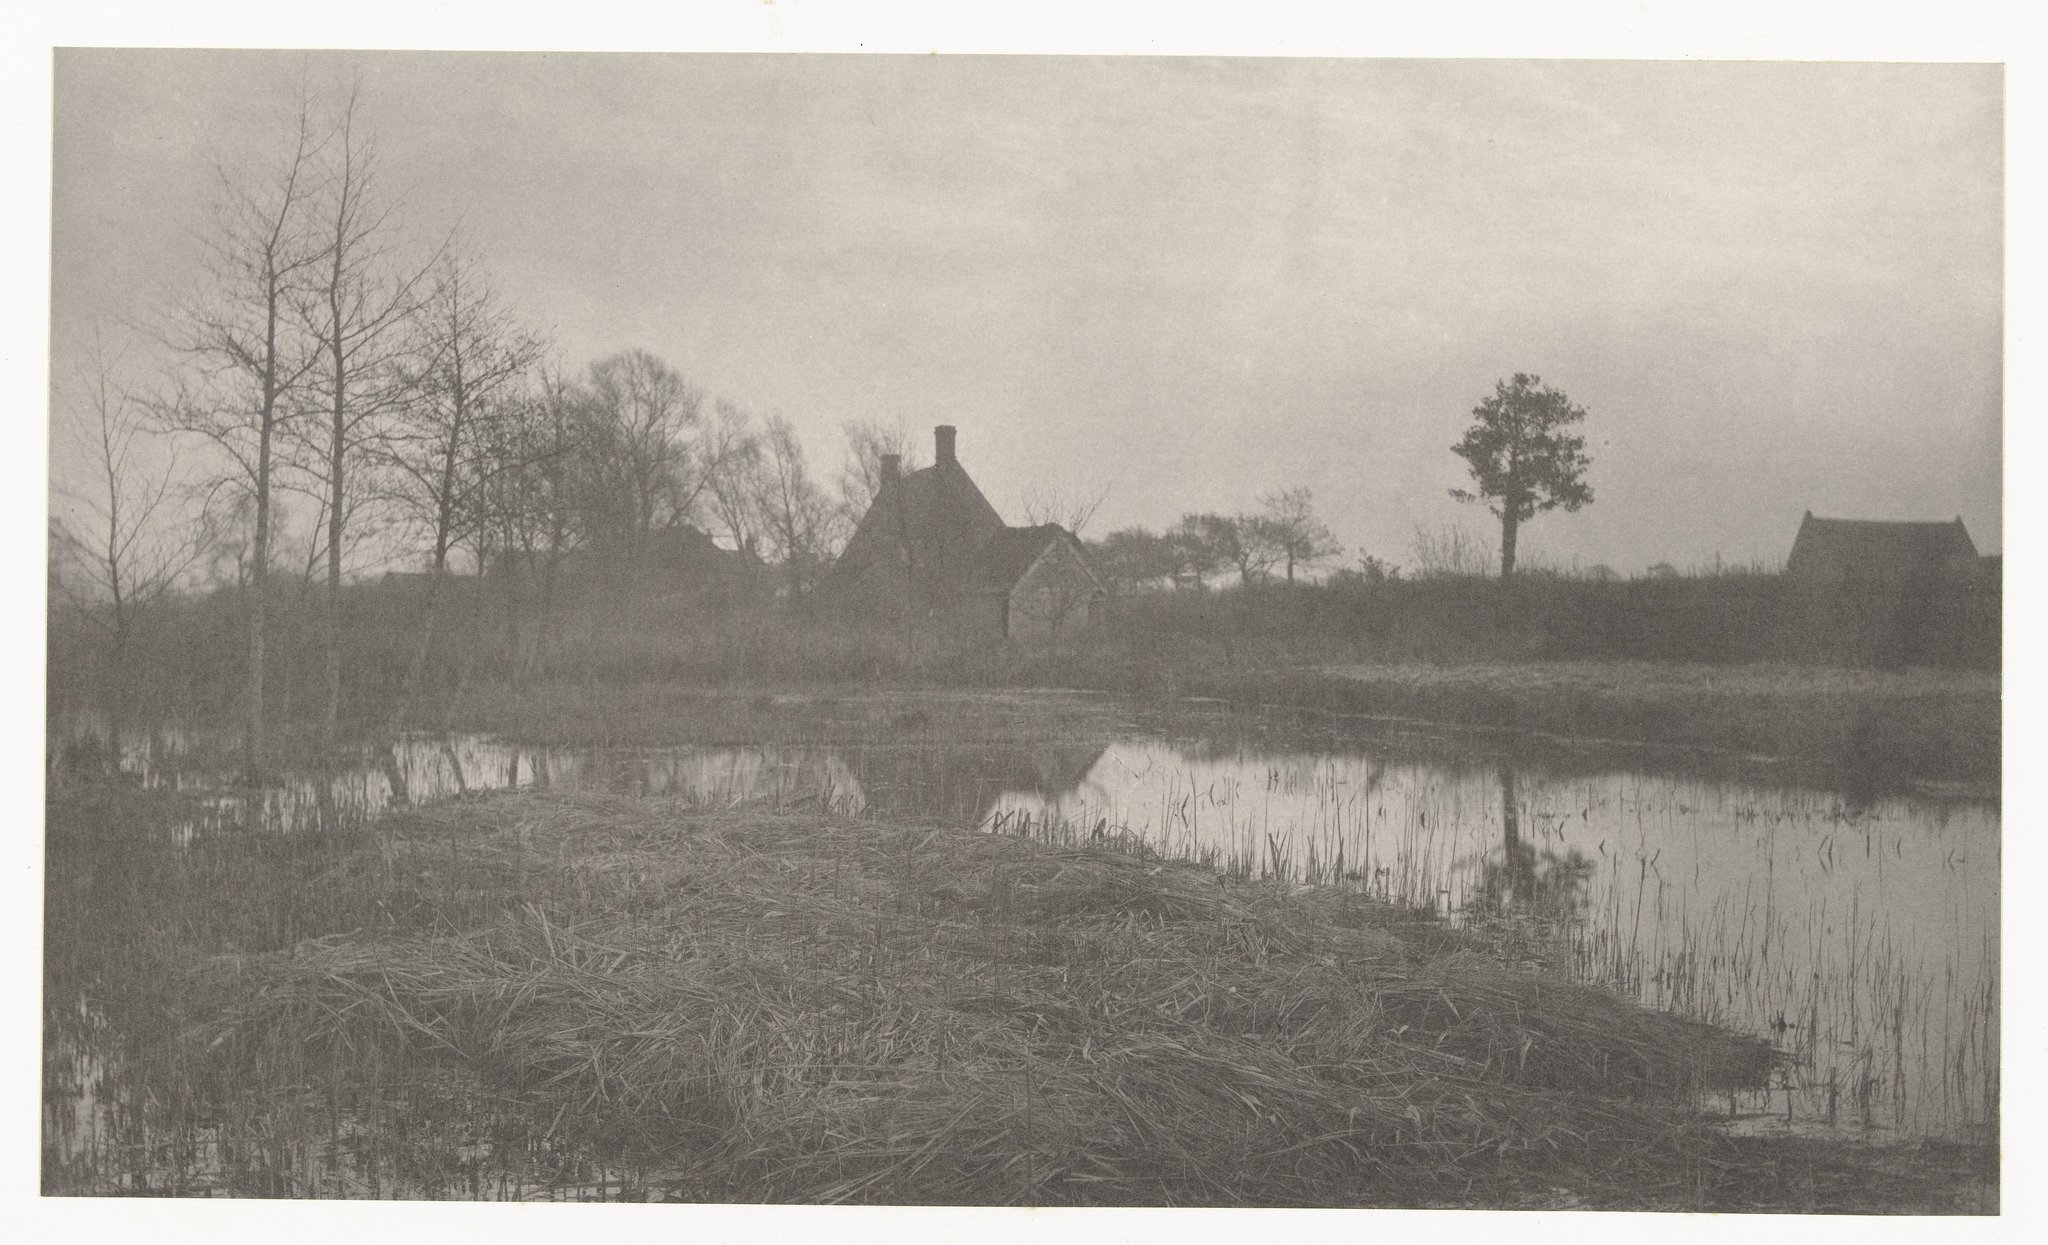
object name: photograph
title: Landschap bij avond op de Norfolk Broads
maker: peter henry emerson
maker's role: fotograaf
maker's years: 1856-1936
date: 1885-1886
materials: cardboard, photographic support, paper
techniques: platinum process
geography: great britain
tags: outskirts of village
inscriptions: inscription: ‘Plate XXXVII.’